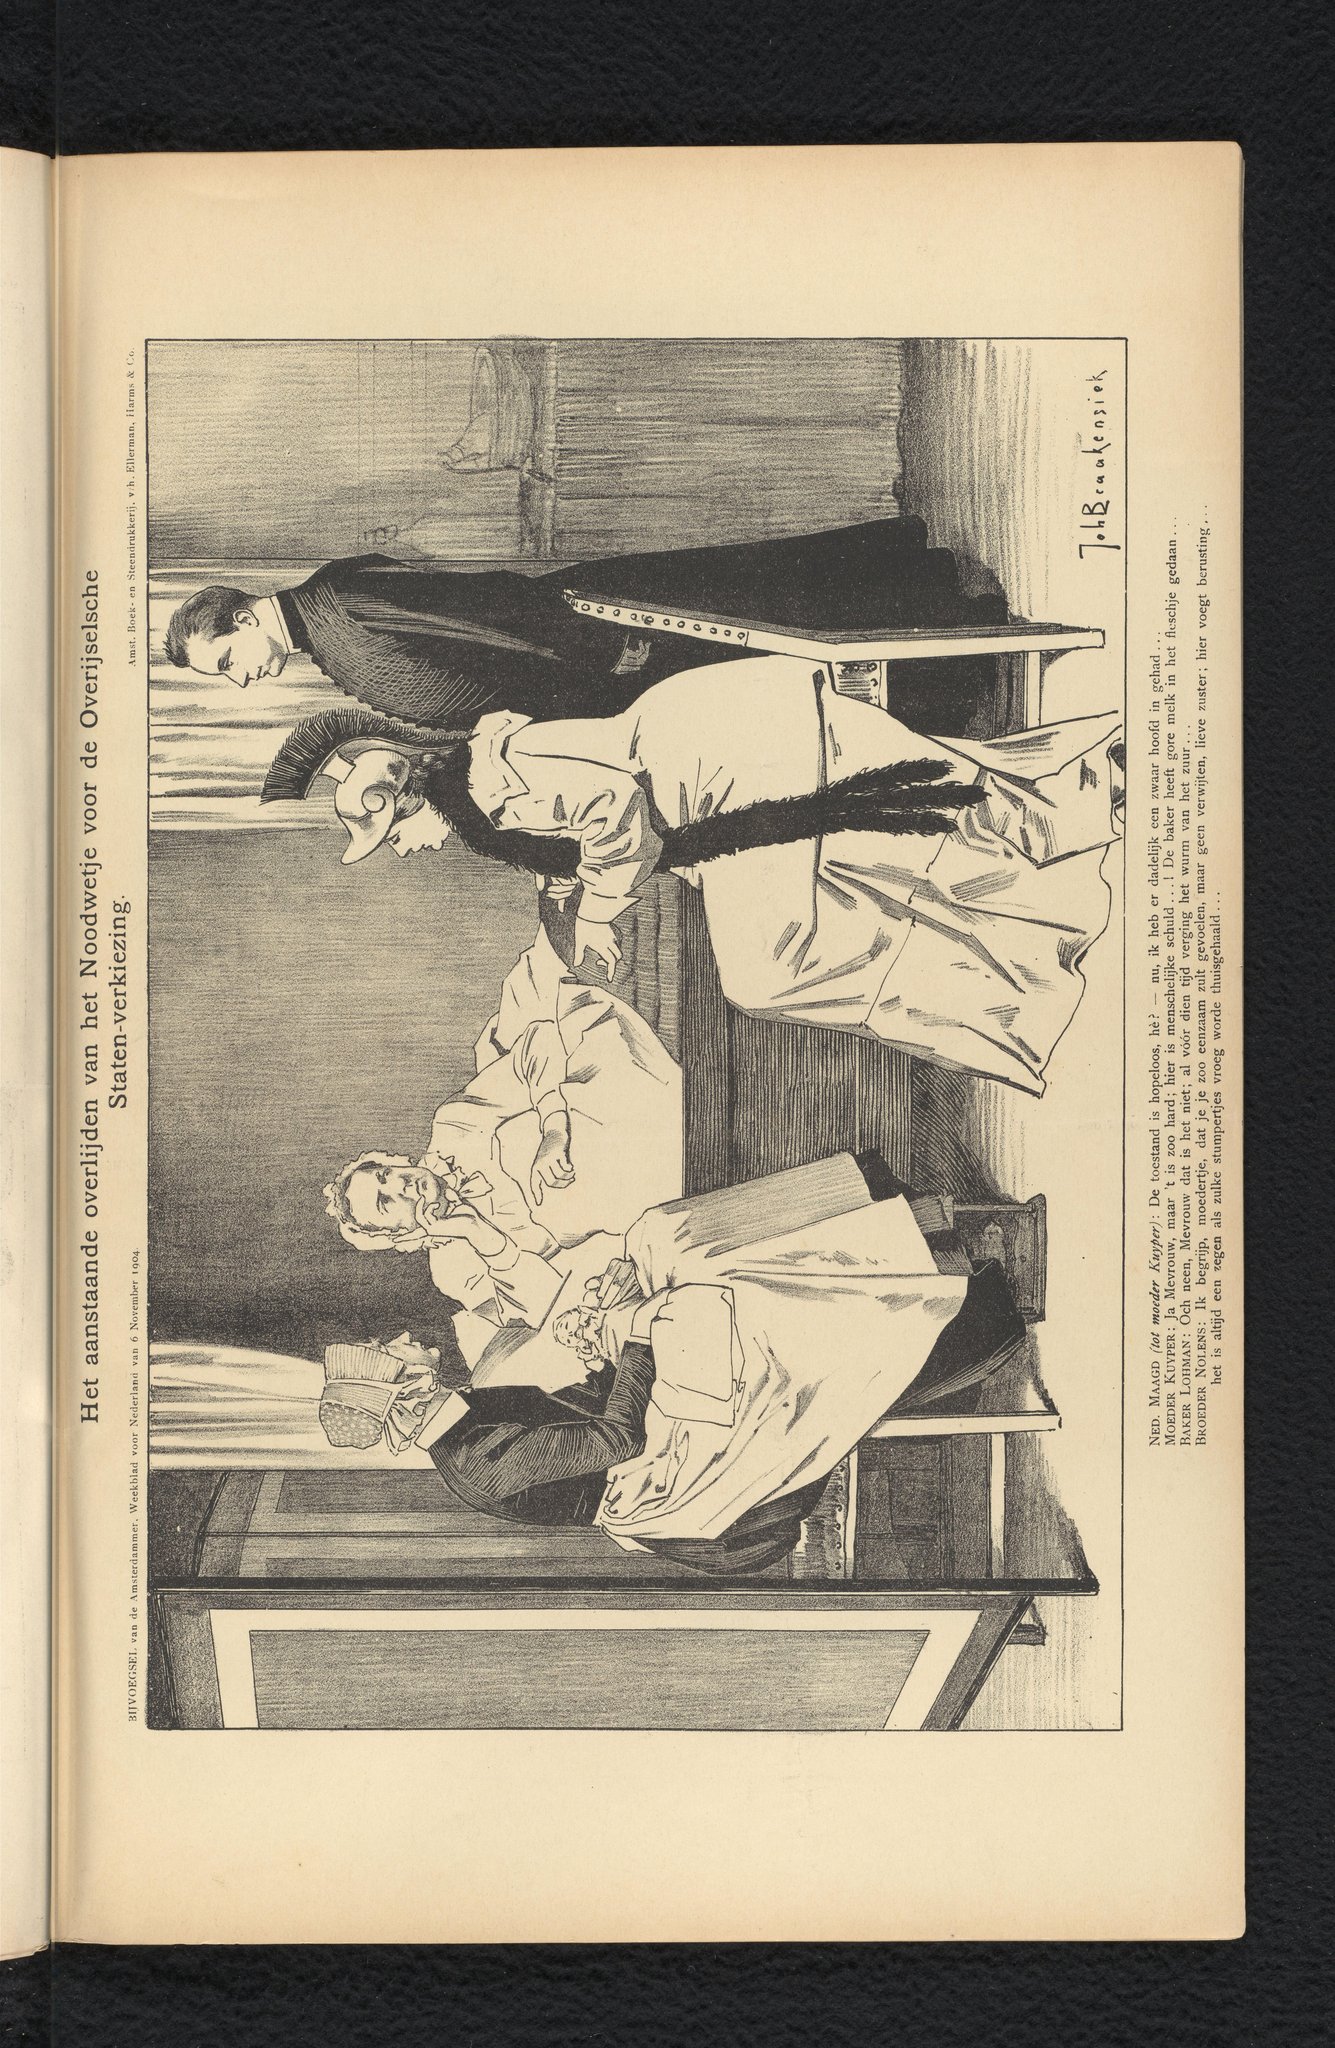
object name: cartoon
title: Het aanstaande overlijden van het Noodwetje voor de Overijsselsche Staten-verkiezing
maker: johan braakensiek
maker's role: draughtsman, print maker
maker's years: 1858-1940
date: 1904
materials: paper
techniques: lithograph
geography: netherlands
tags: the hague, jonkheer alexander frederik de savornin lohman, abraham kuyper, priest, personifications of countries, nations, states, districts, etc., visiting the new mother, lying-in visit, dry-nurse, political caricatures and satires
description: De Nederlandse Maagd op kraambezoek bij moeder Kuyper vanwege het aanstaande overlijden van het miezerige pasgeboren kind (de Overijsselse noodwet). Kuypers verwijt baker Lohman dat er zure melk in de fles zat. Willem Nolens is als priester aanwezig.